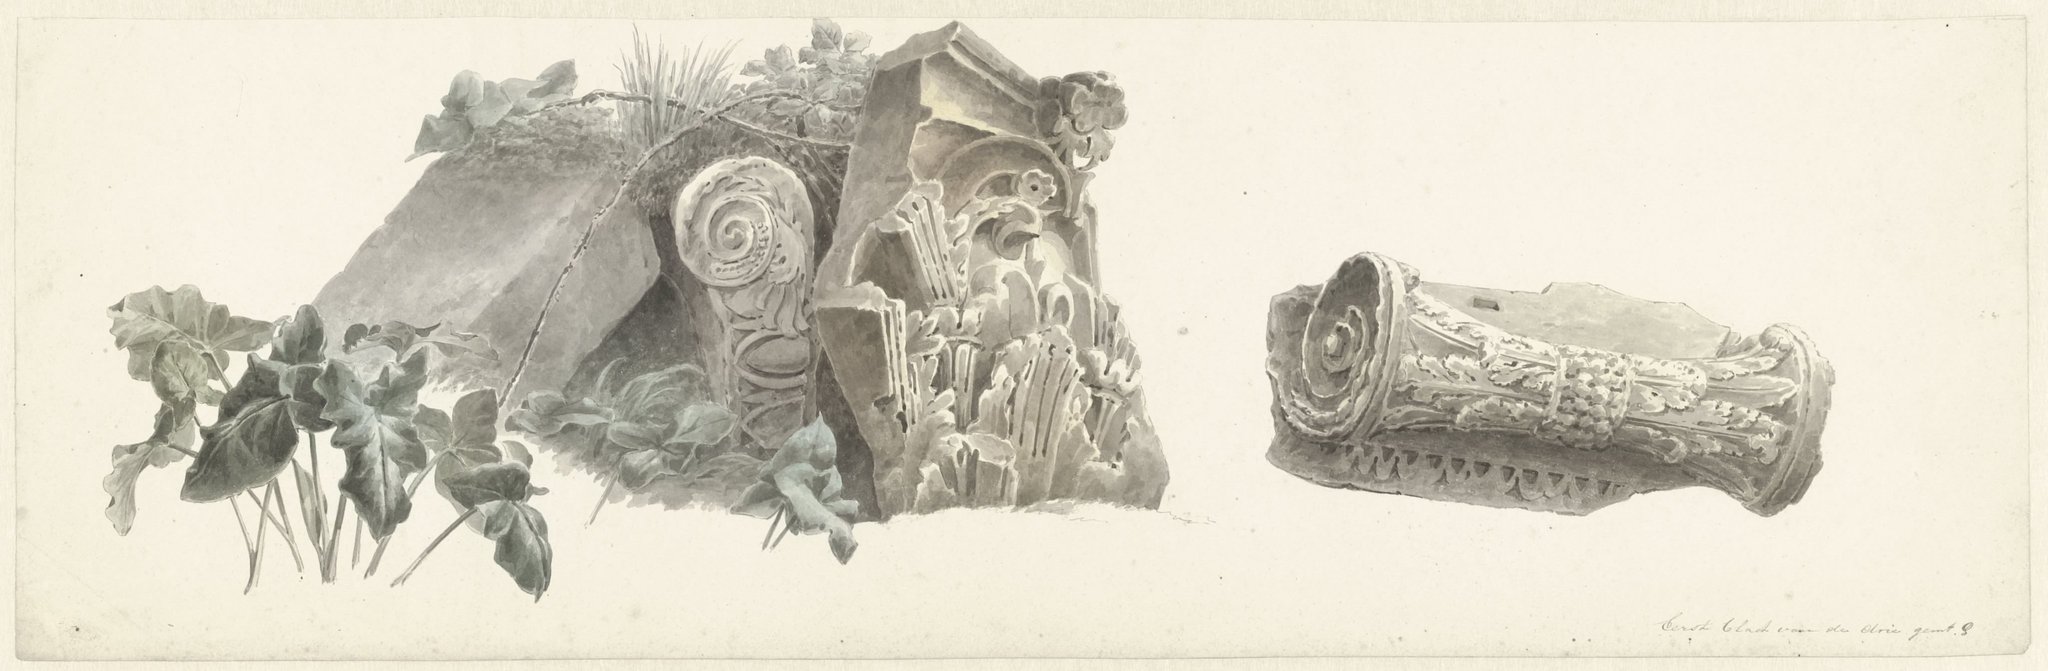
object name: drawing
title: The Baths of Caracalla and Two Capitals from the Villa Mattei in Rome Five Capitals in the Villa Mattei in Rome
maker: josephus augustus knip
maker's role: draughtsman, painter, print maker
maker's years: 1777-1847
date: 1809-1812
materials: graphite, paper, watercolor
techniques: brush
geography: italy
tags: capital (~ column, pillar), italy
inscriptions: inscription: ‘Eerste blad van de drie gemt. Q’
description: Originally, these two drawings were the lower halves of the two sheets on the right with a panoramic view of the Baths of Caracalla. The view continues in the drawing on the far right. To indicate that the sheets belonged together, Knip marked them with a capital Q. Who cut two of the three drawings in half and why he did so remains unclear.